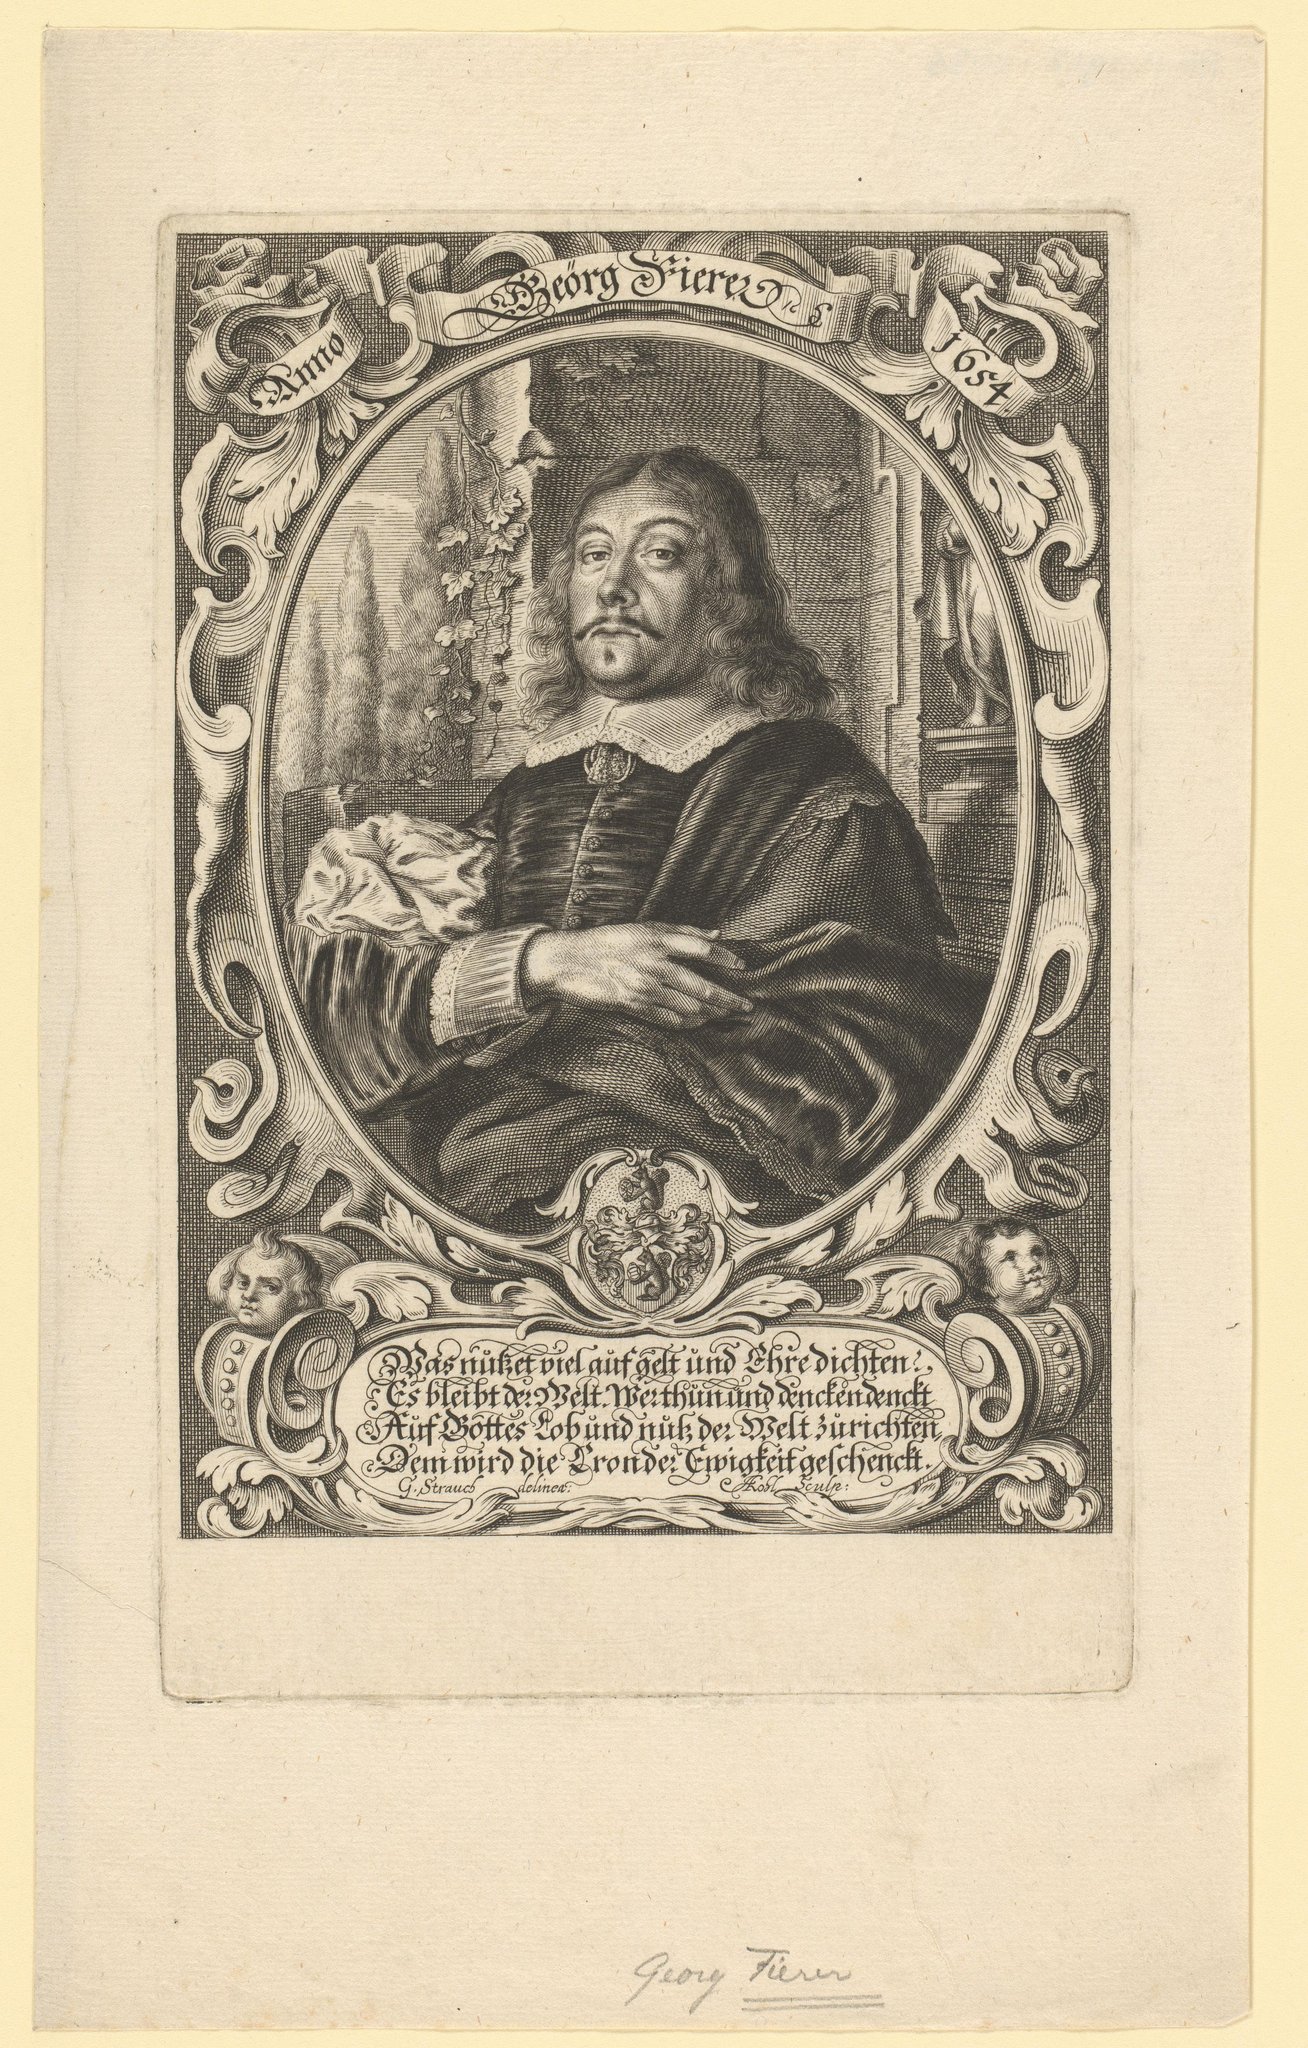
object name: print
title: Portret van Georg Fürer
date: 1654-1657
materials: paper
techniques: engraving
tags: historical persons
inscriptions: collector's mark: Lugt 2228